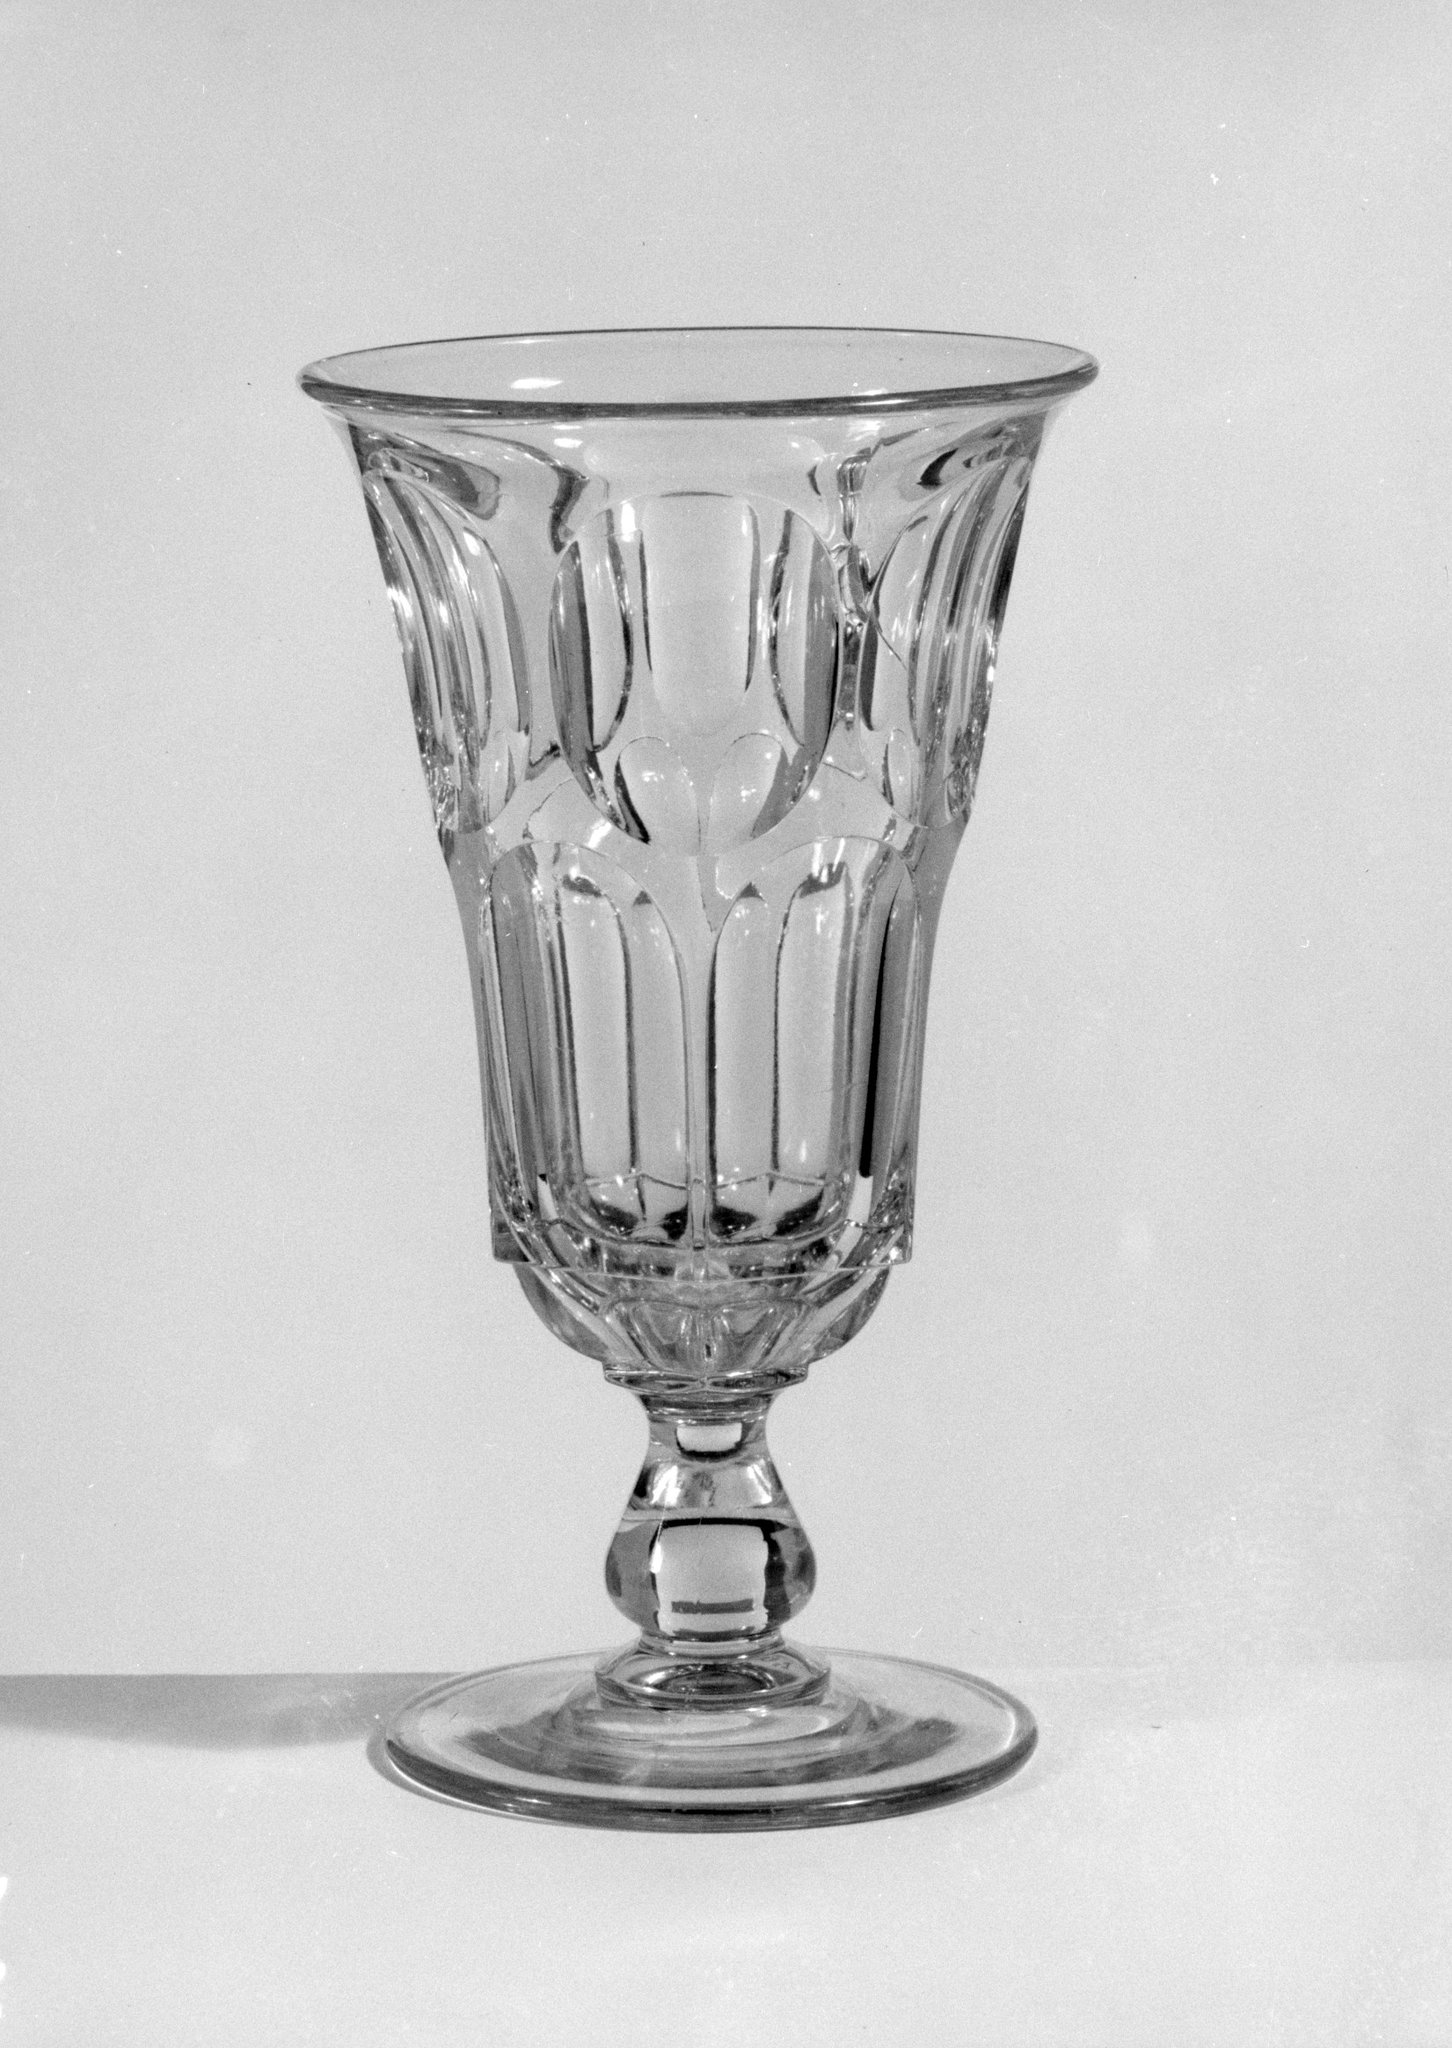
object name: celery vase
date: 1850-1870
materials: diamond, glass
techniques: pressed